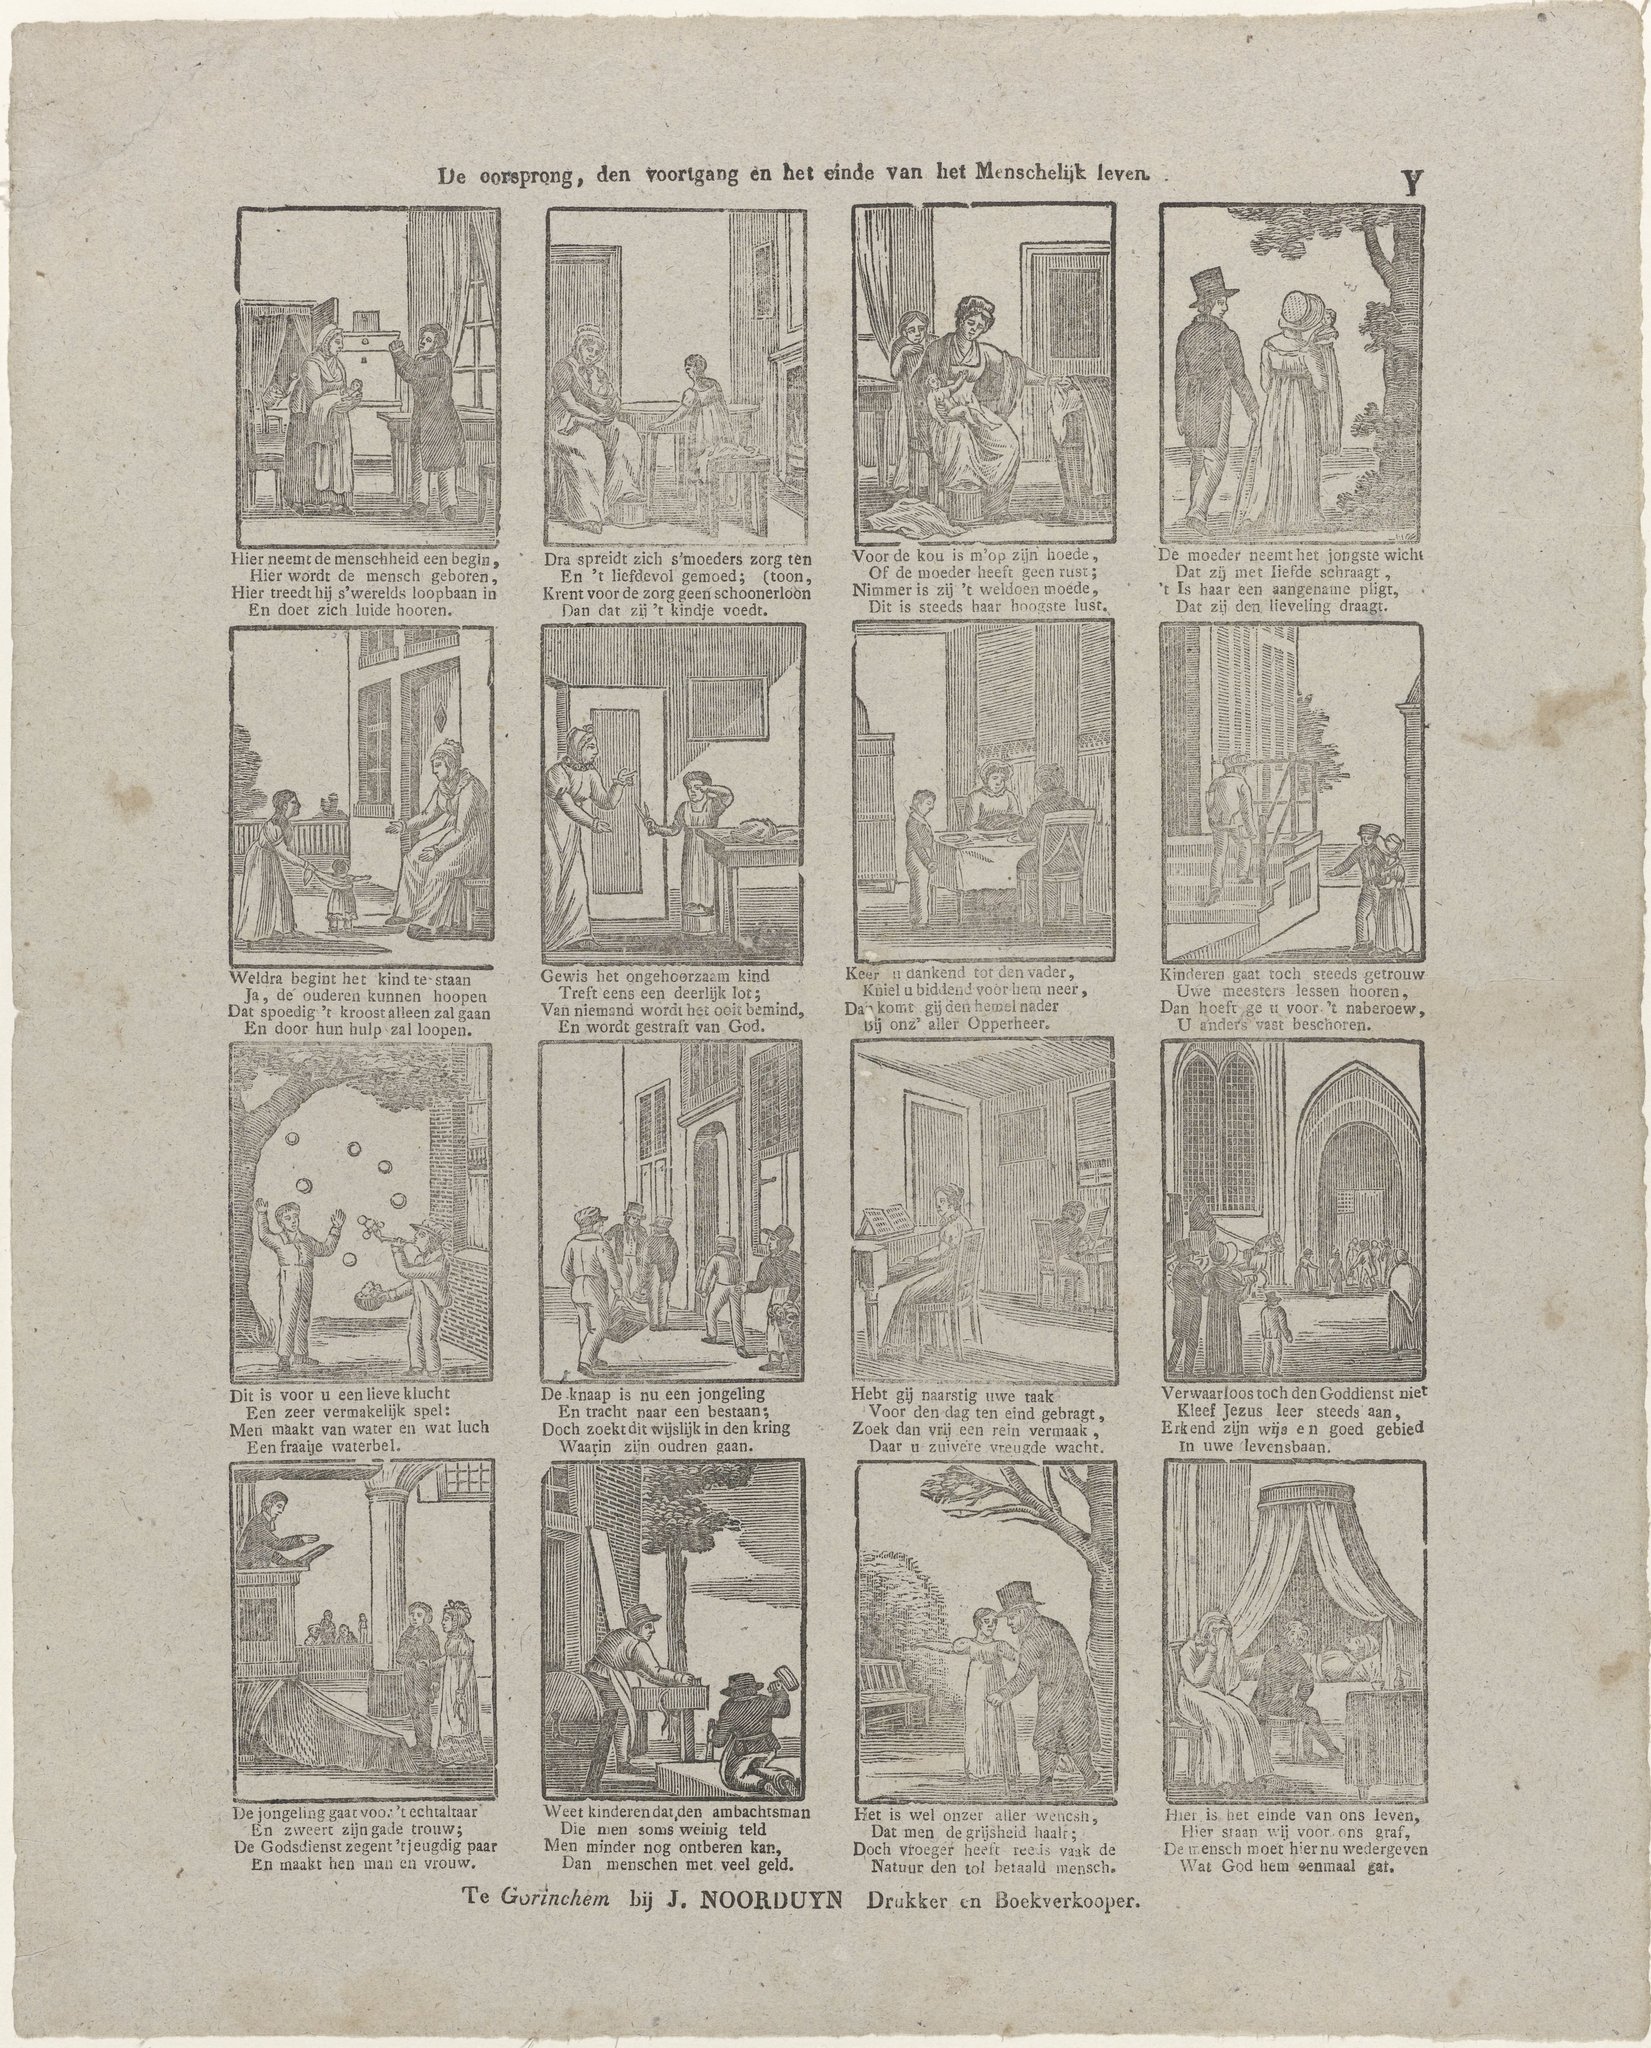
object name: popular print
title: Den oorsprong, voortgang en het einde van het menschelijk leven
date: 1819-1840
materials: paper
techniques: letterpress printing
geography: gorinchem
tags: human life divided into stages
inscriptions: collector's mark: Lugt 2760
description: Blad met 16 voorstellingen van verschillende stadia in het menselijk leven, van geboorte tot de dood. Onder elke afbeelding een vierregelig vers. Gemerkt rechtsboven: Y.